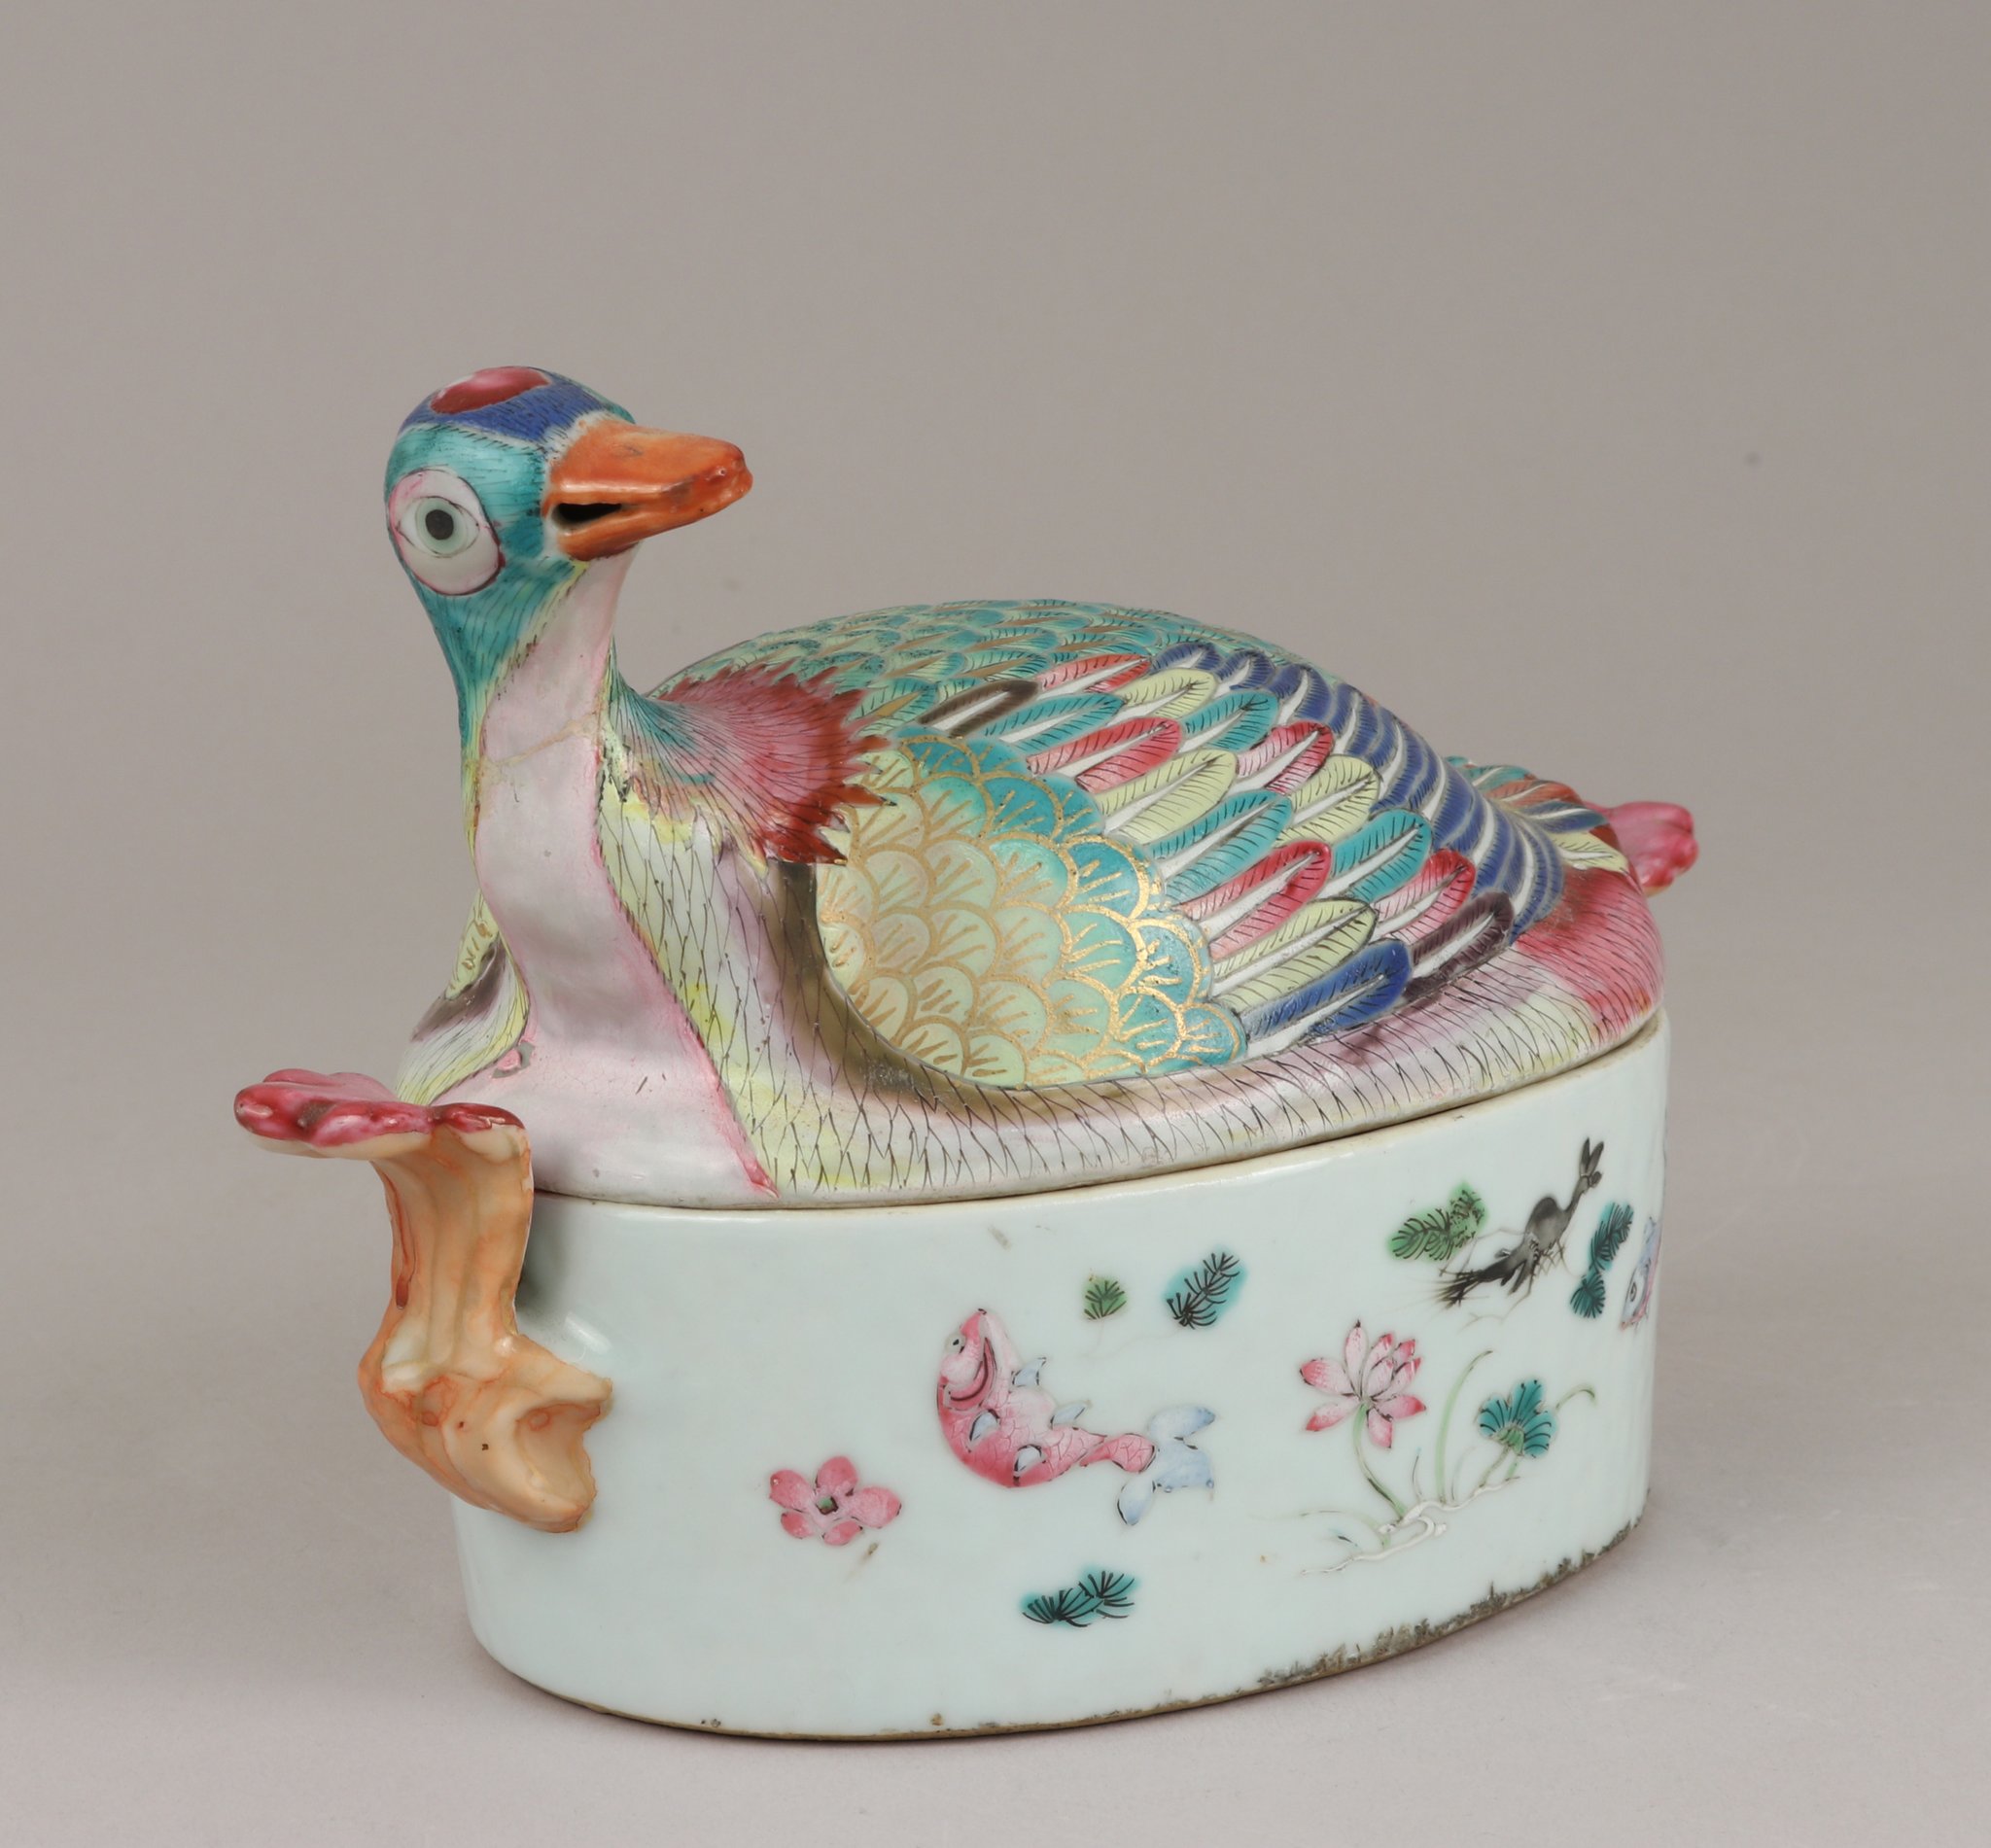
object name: tureen with cover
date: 1801-1900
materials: hard paste porcelain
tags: ducks,fish